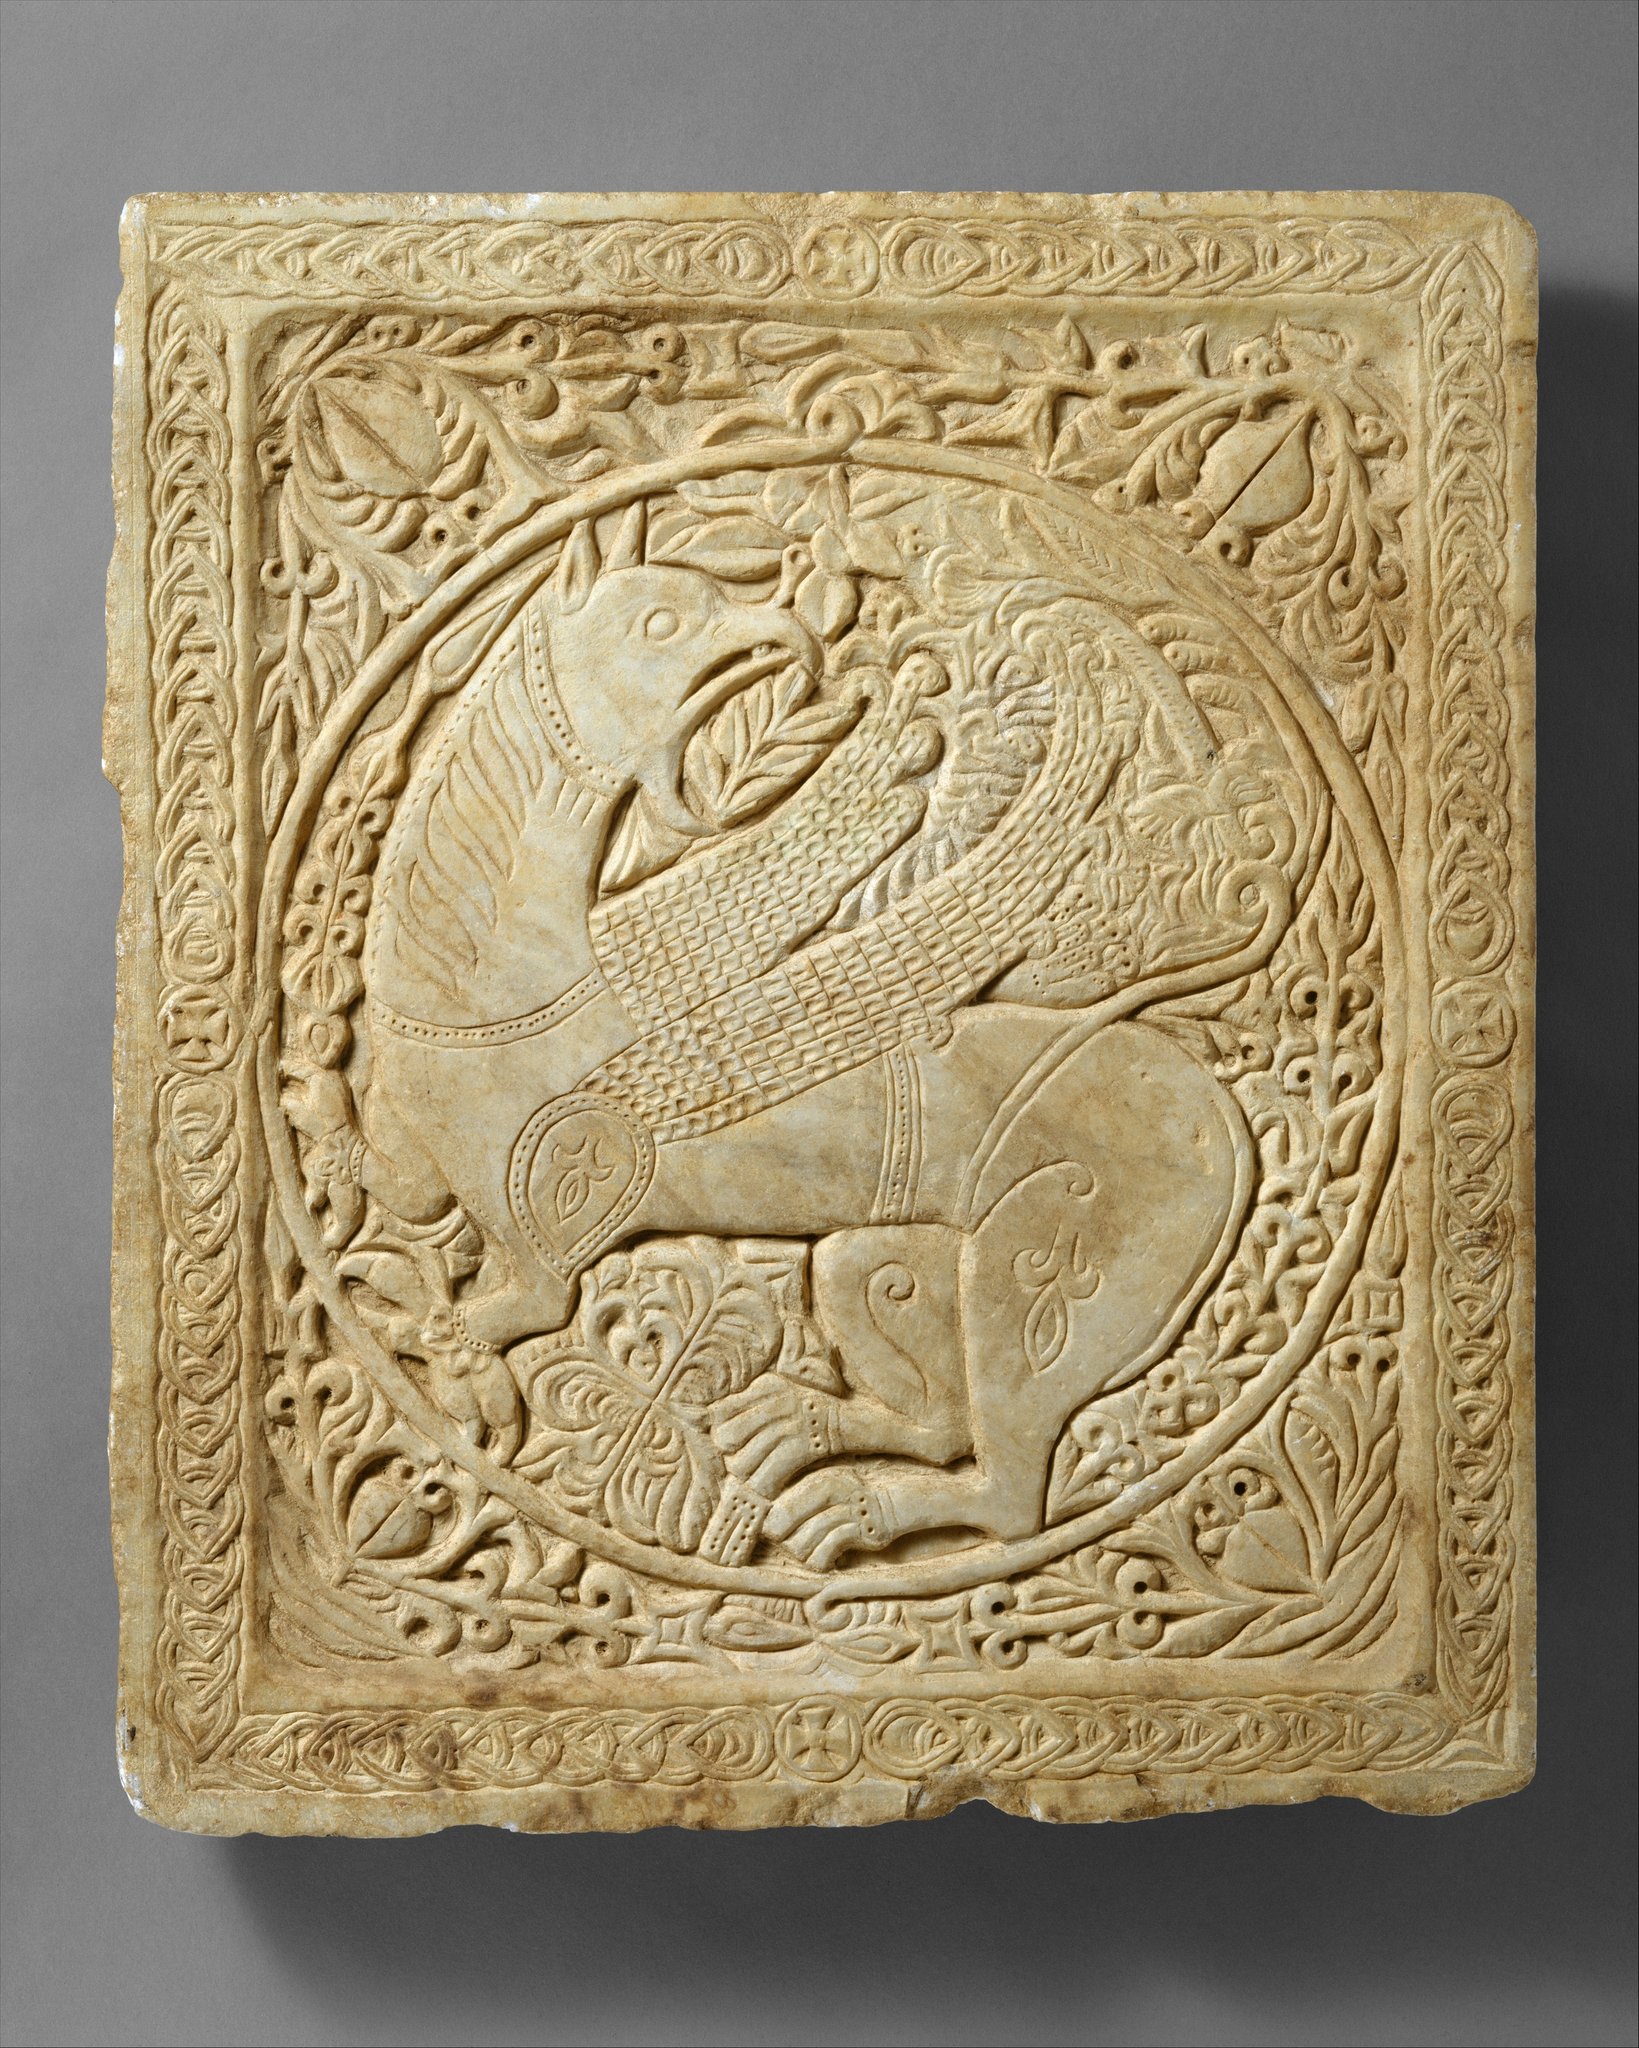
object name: relief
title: Panel with a Griffin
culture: byzantine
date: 1250-1300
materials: marble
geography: greece or the balkans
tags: griffins